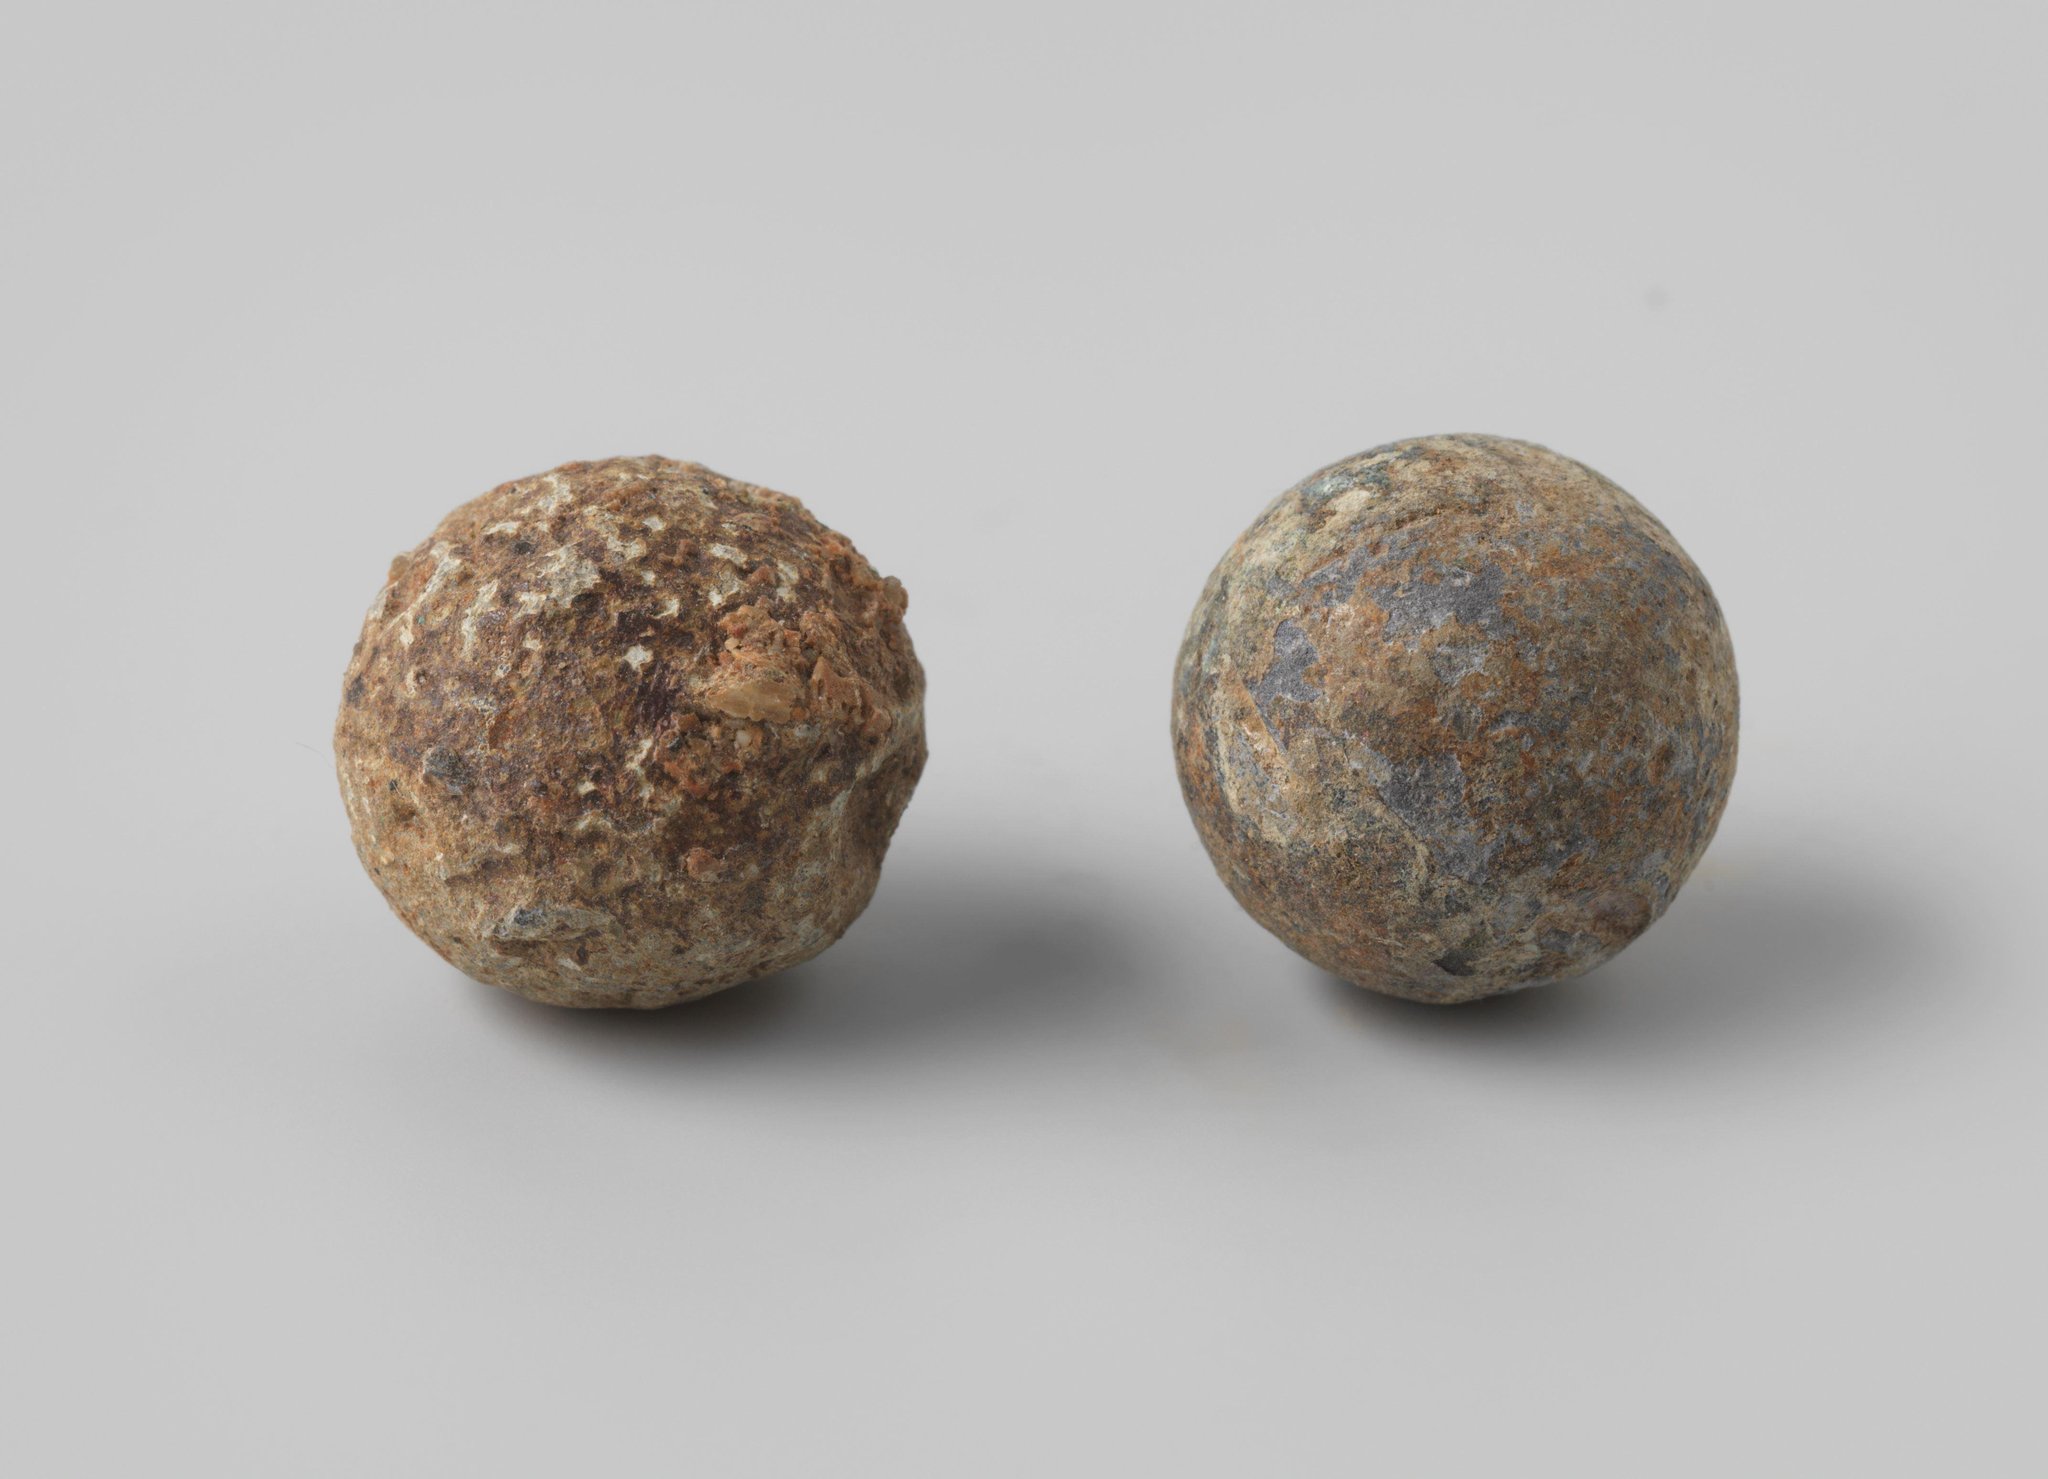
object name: musketkogel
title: Musketkogel uit het wrak van de Oost-Indiëvaarder Hollandia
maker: Anonymous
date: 1700-1743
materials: lead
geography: netherlands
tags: verenigde oostindische compagnie, hollandia (schip), annet